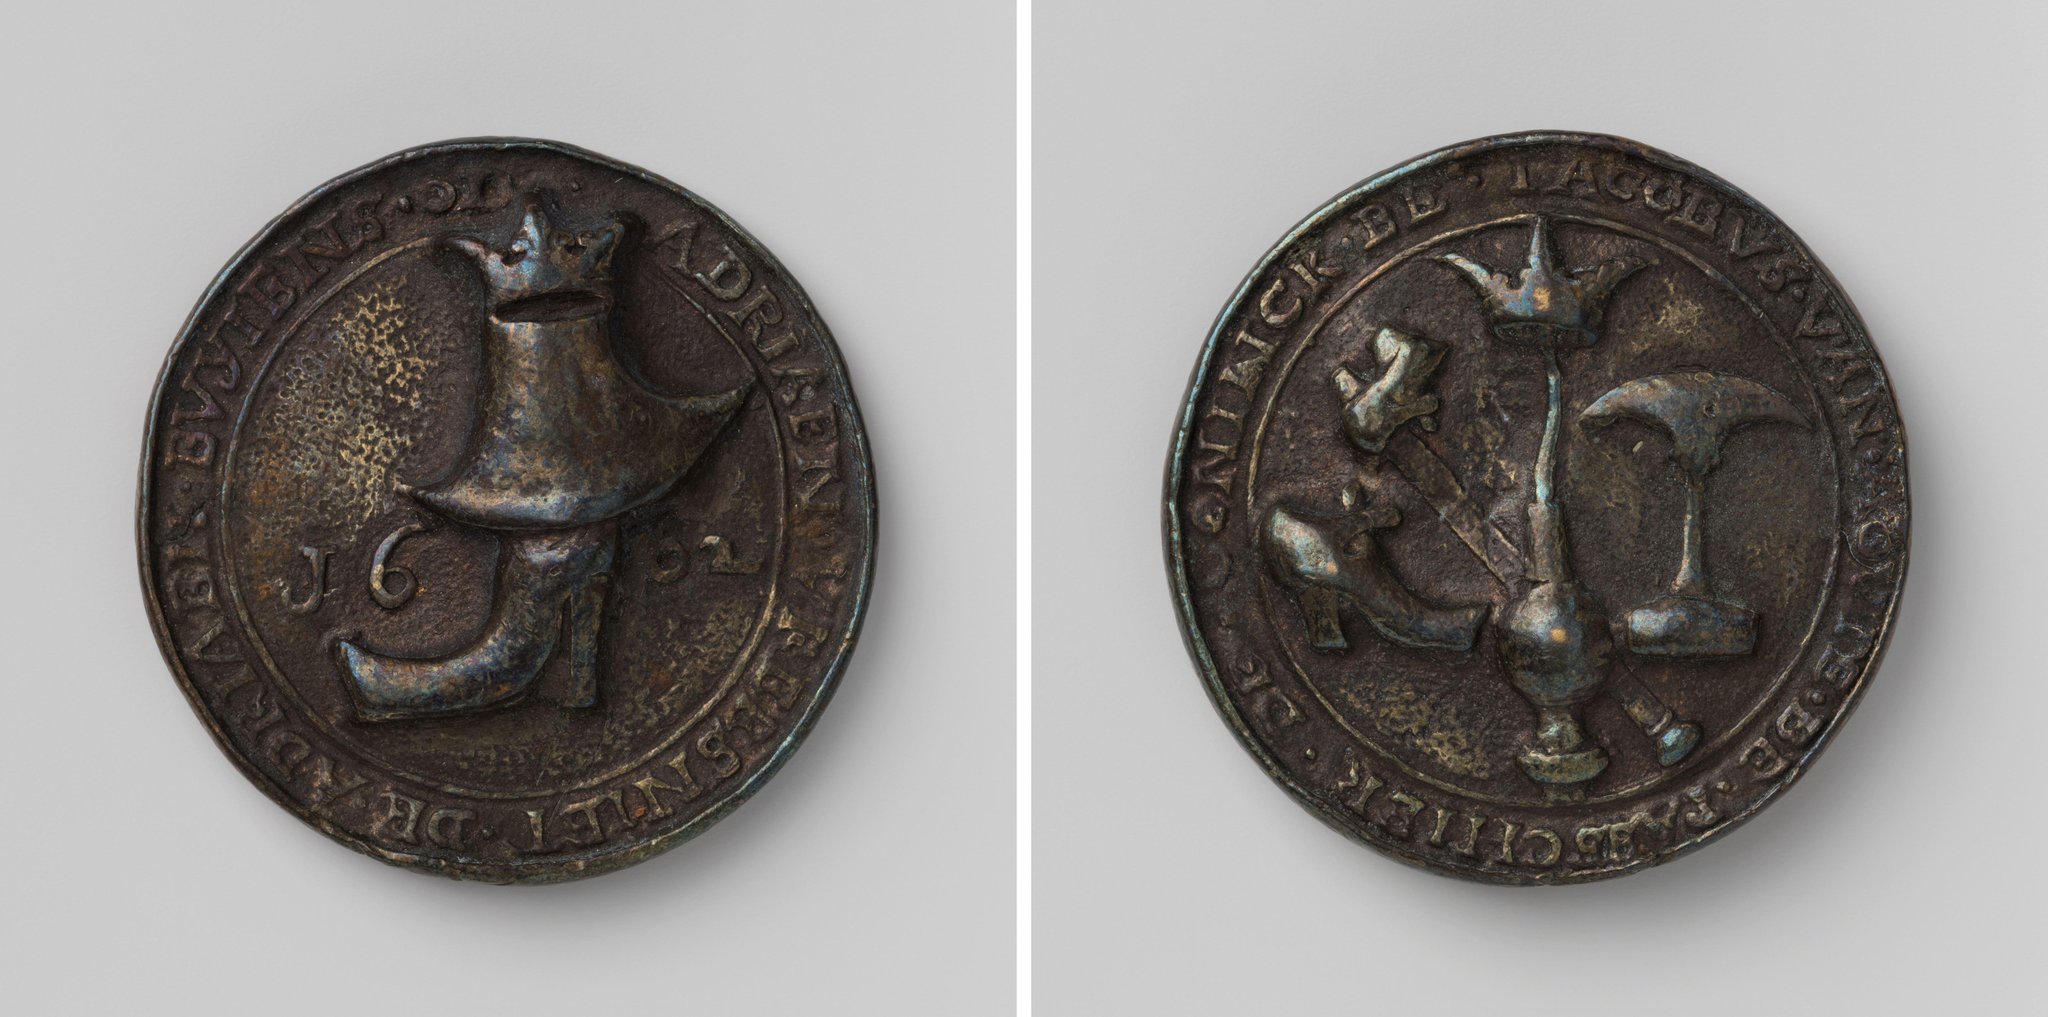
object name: medal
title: Schoenmakers-, huidenvetters- en leerverkopersgilde van Middelburg, gildepenning met no. 20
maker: Anonymous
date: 1662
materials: brass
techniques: casting, engraving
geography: middelburg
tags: middelburg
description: Guilds were urban organisations of people in specific occupations. The guild represented the interests of the profession. Each member had a token as proof of membership. The person’s name was engraved on one side of the token, often together with the arms of the guild or of the city in which it was based. The other side carried a motif signifying the occupation represented by the guild.